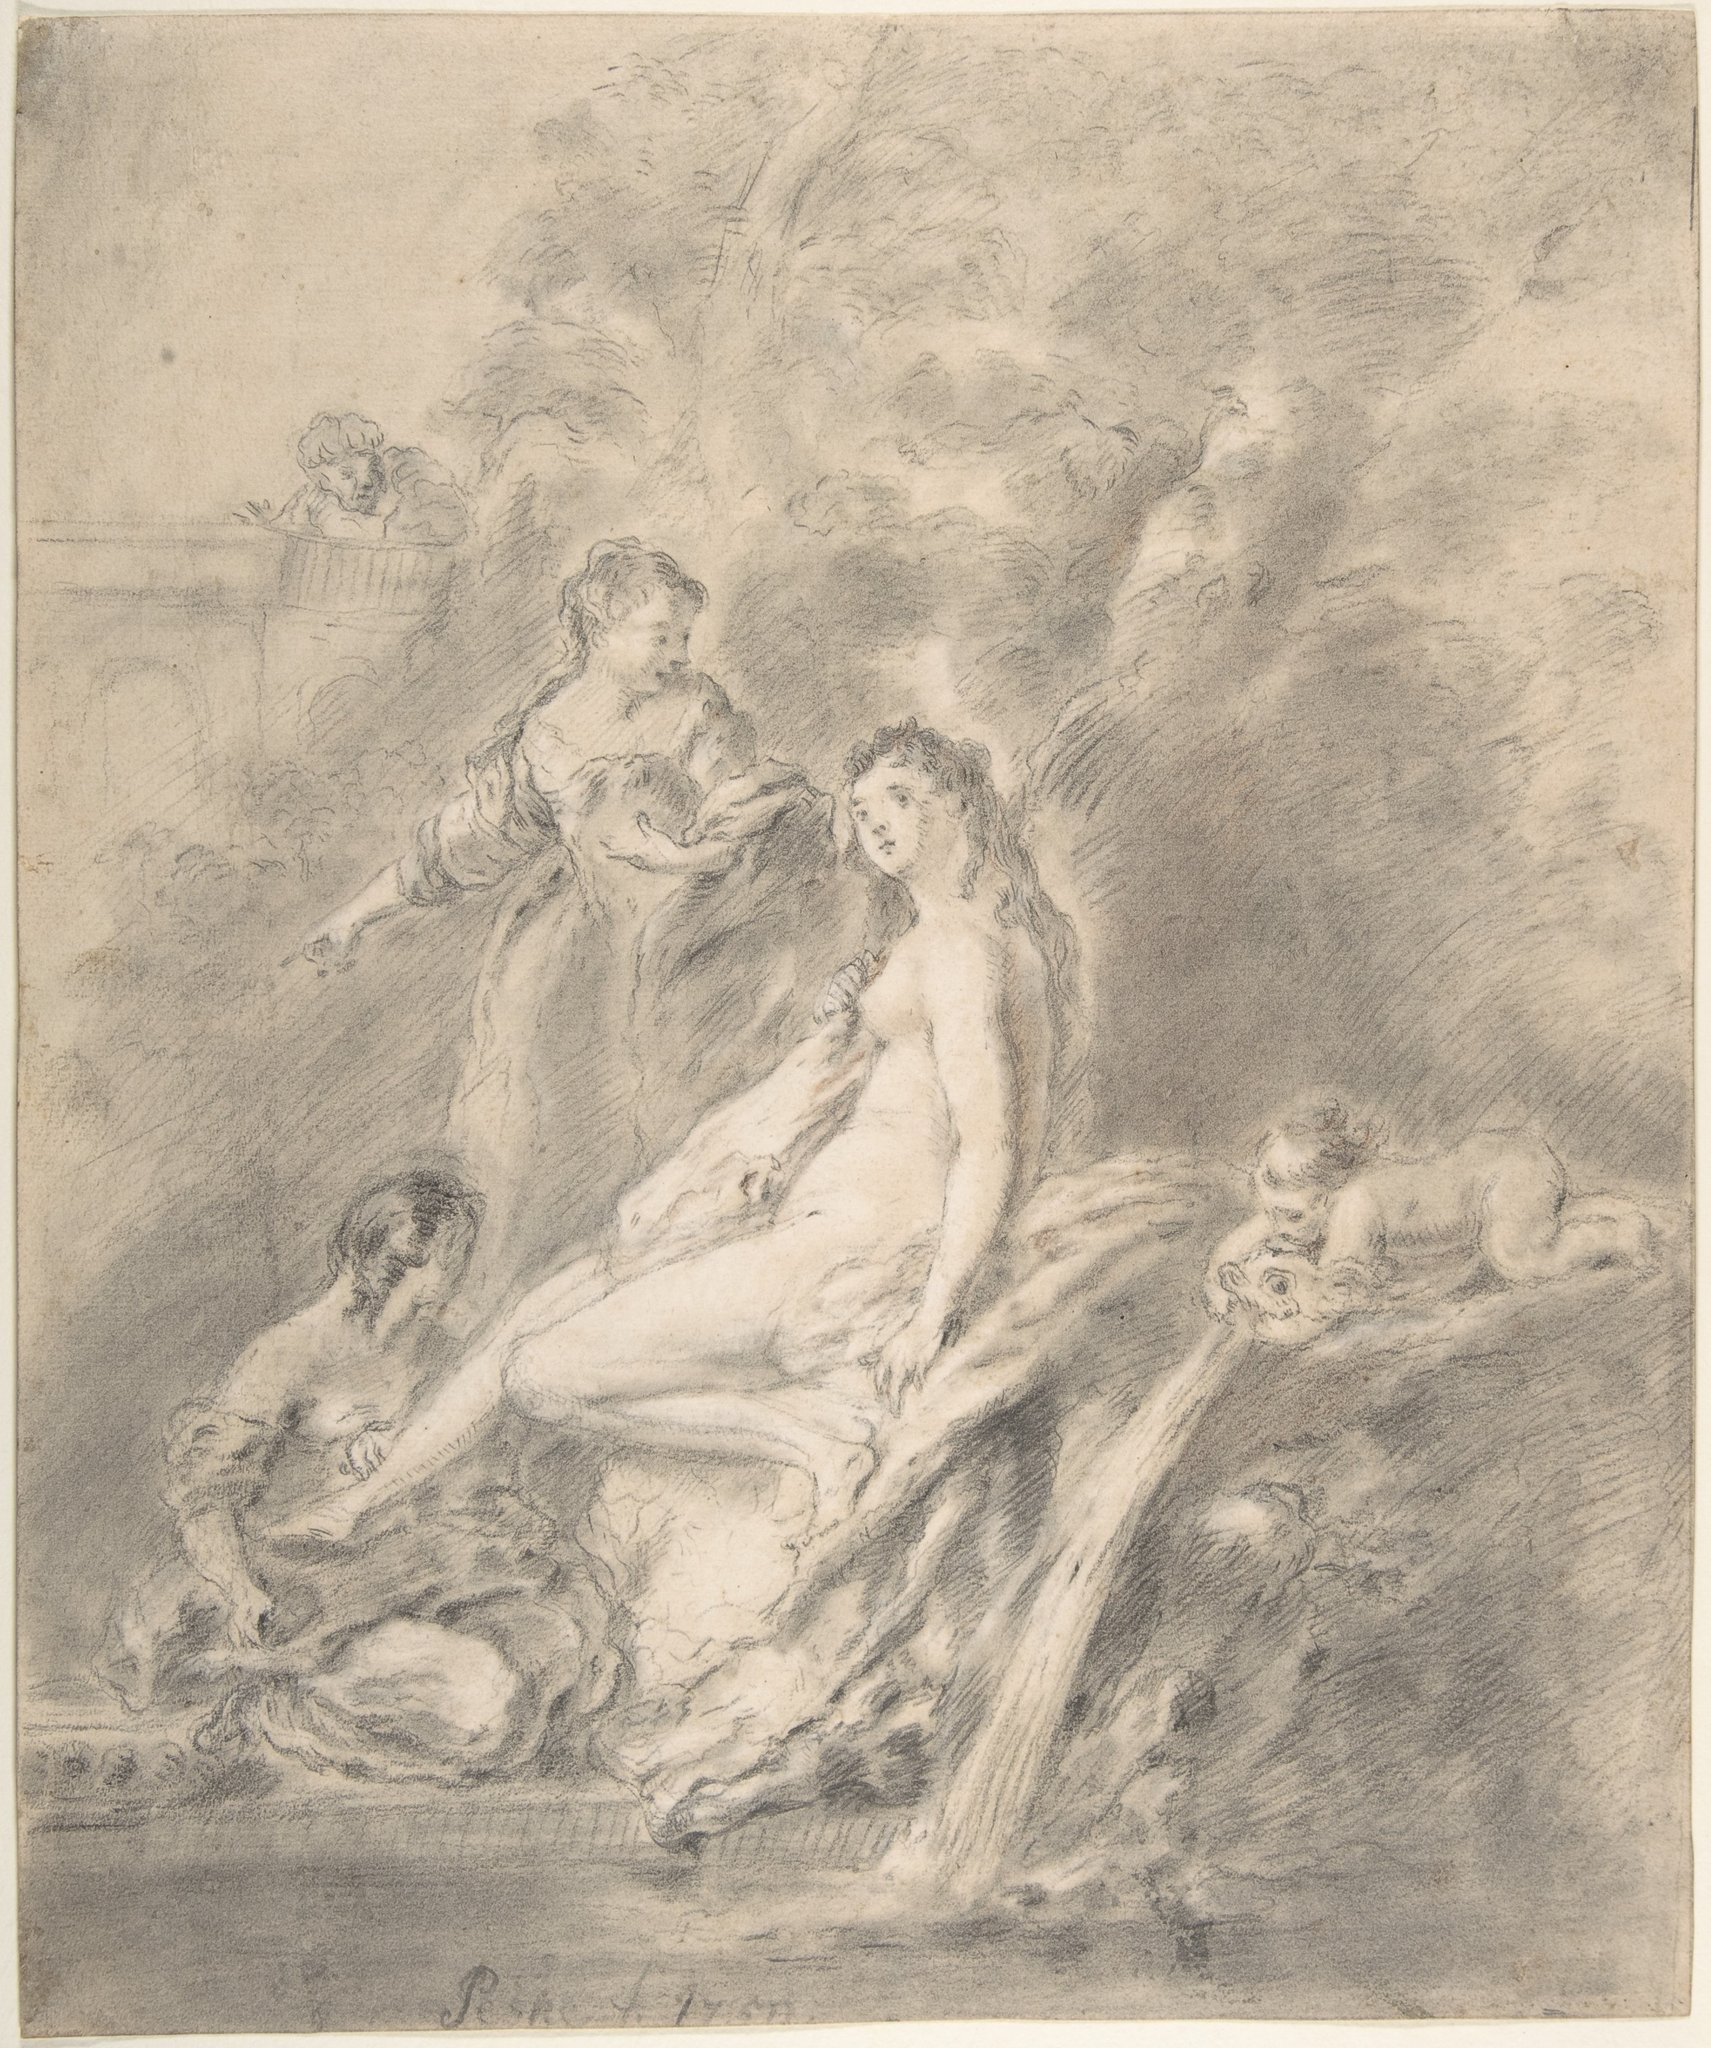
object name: drawing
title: Bathsheba at the Bath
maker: antoine pesne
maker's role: artist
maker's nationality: french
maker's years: 1683-1757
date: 1750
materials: chalk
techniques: heightening, stumping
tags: children,women,bathsheba,bathing